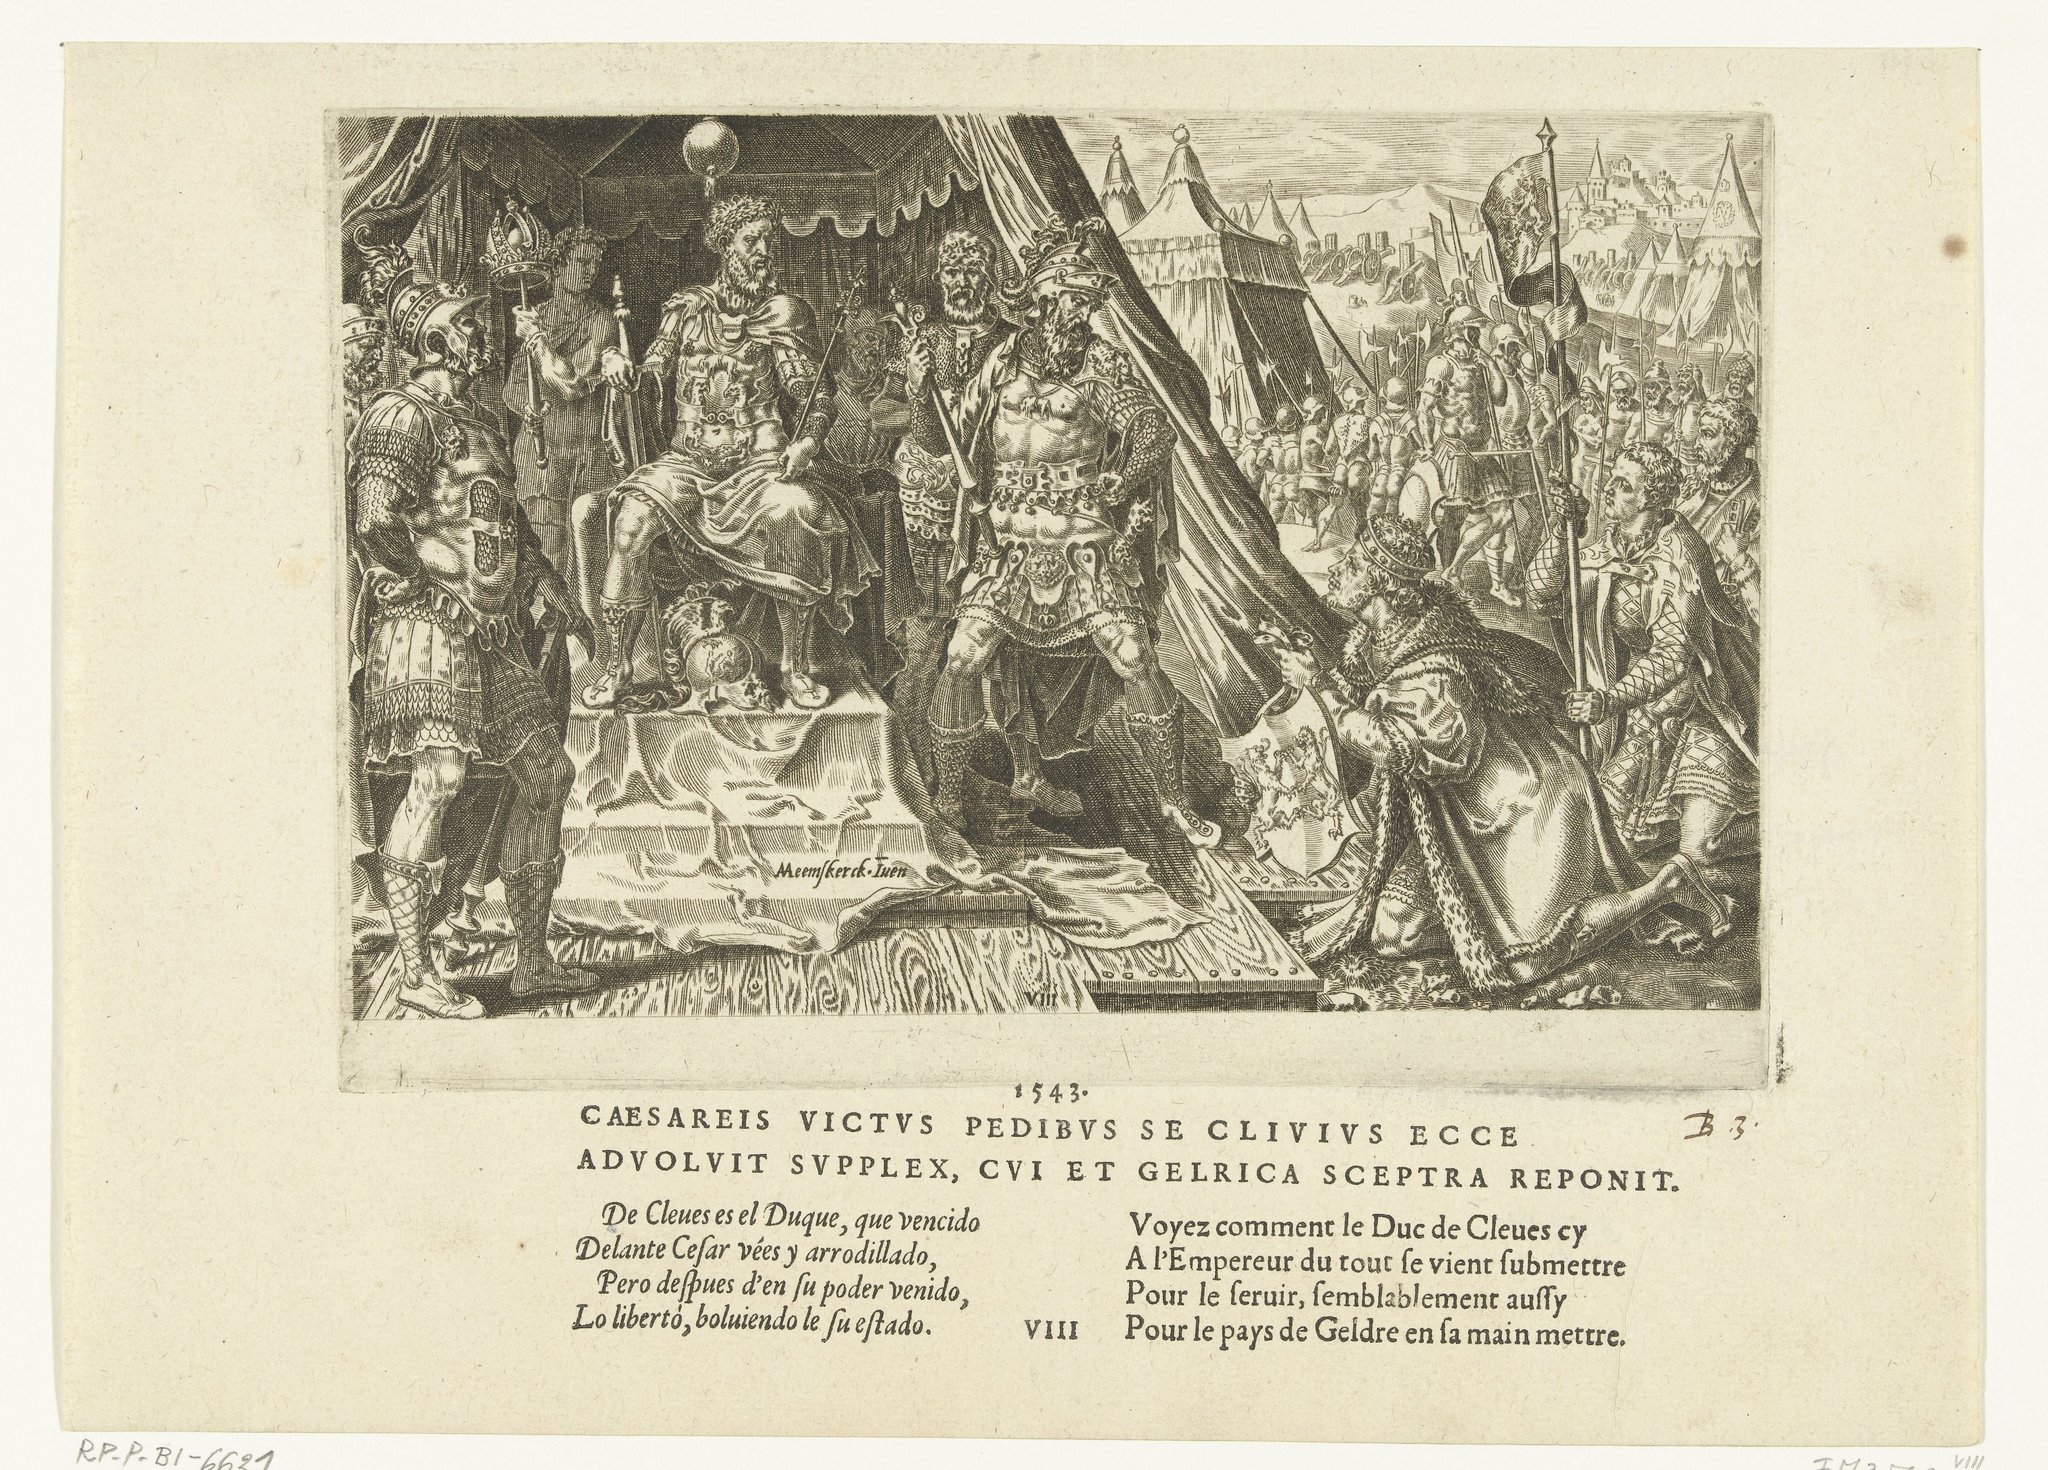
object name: propagandaprent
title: Triomfen van Karel V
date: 1555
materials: paper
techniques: engraving, etching, letterpress printing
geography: northern netherlands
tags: ghent, charles v (holy roman emperor and king of spain), surrender ~ war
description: Onderwerping van Willem V van Kleef in 1543. De hertog knielt voor de keizer in zijn legertent. Onderschriften in twee regels Latijn, vier regels Spaans en vier regels Frans.